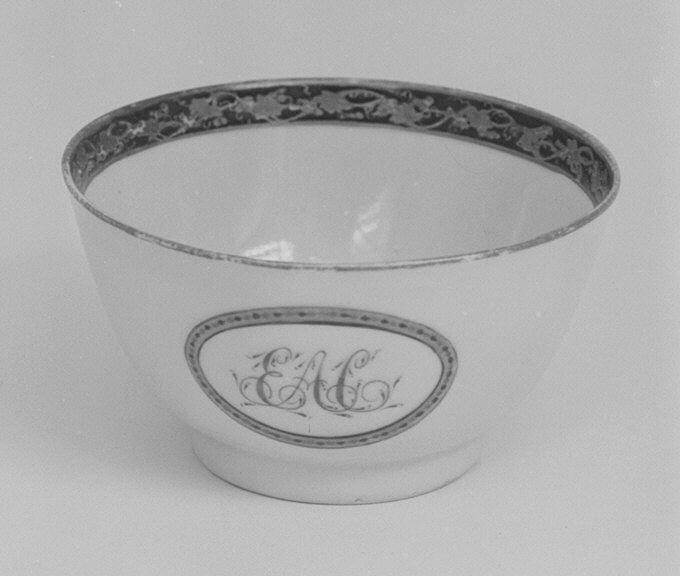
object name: cup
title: Cup (part of a service)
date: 1790-1800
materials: hard paste porcelain